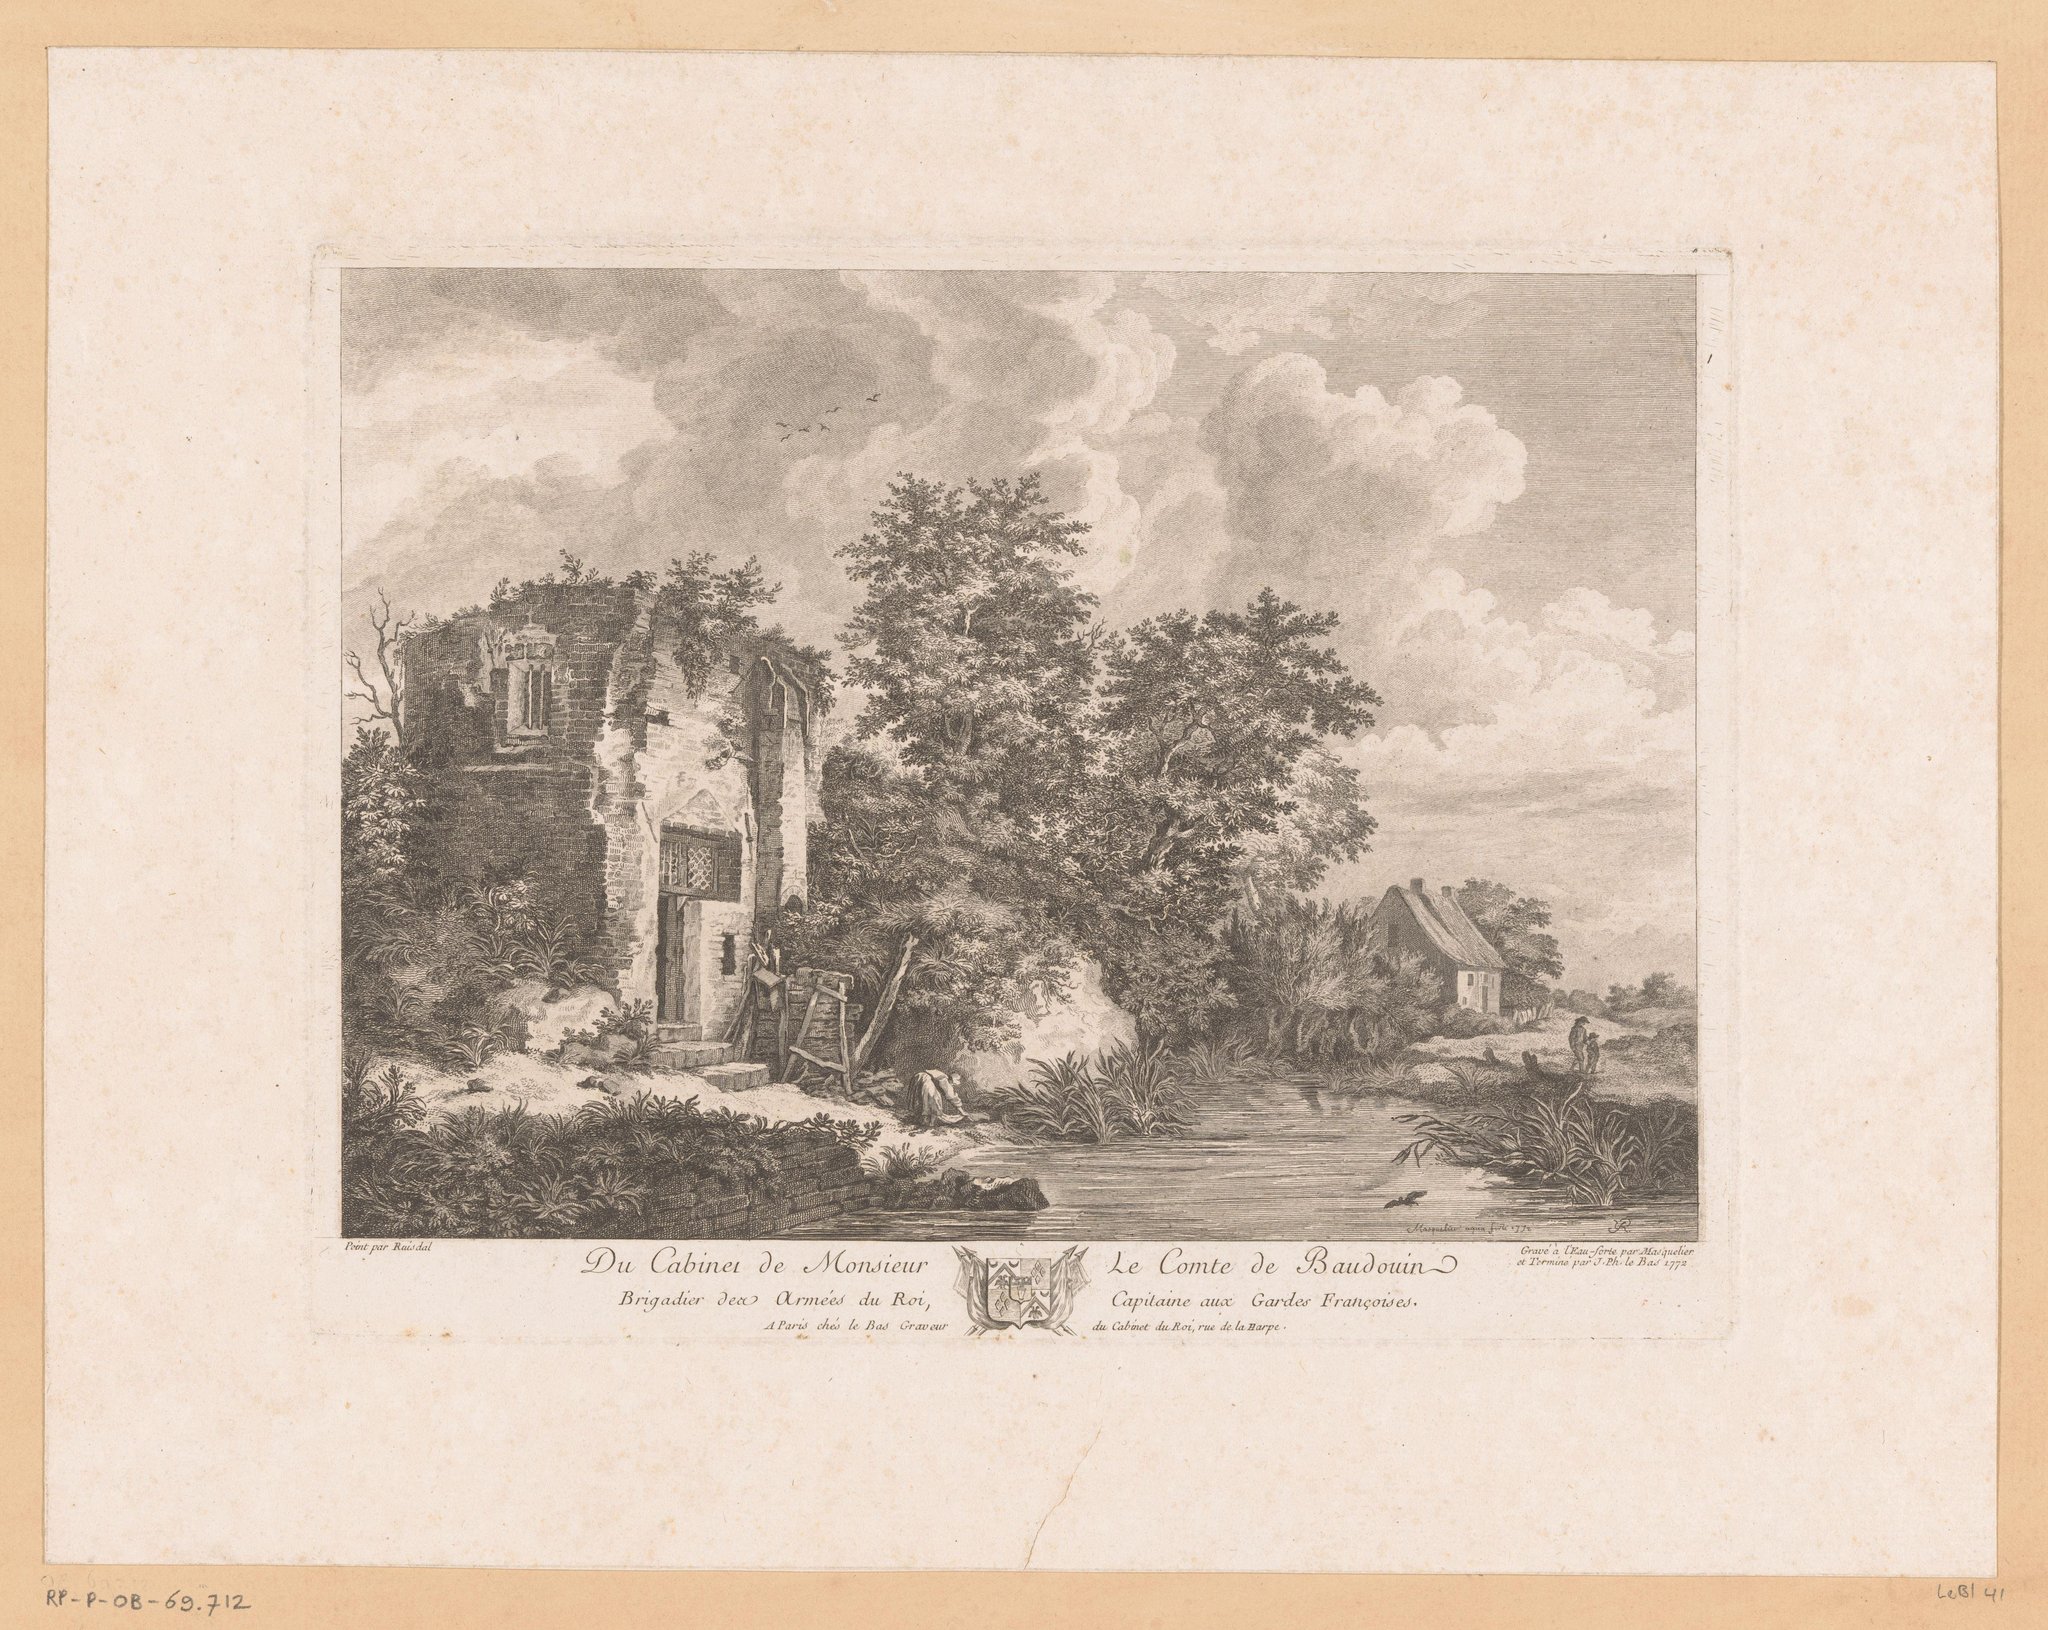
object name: print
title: Vervallen huis aan een rivier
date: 1772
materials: paper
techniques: engraving, etching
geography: paris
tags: rural housing, e.g. country-house, villa, cottage, ruin of a dwelling, house, castle, etc.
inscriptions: collector's mark: Lugt 240